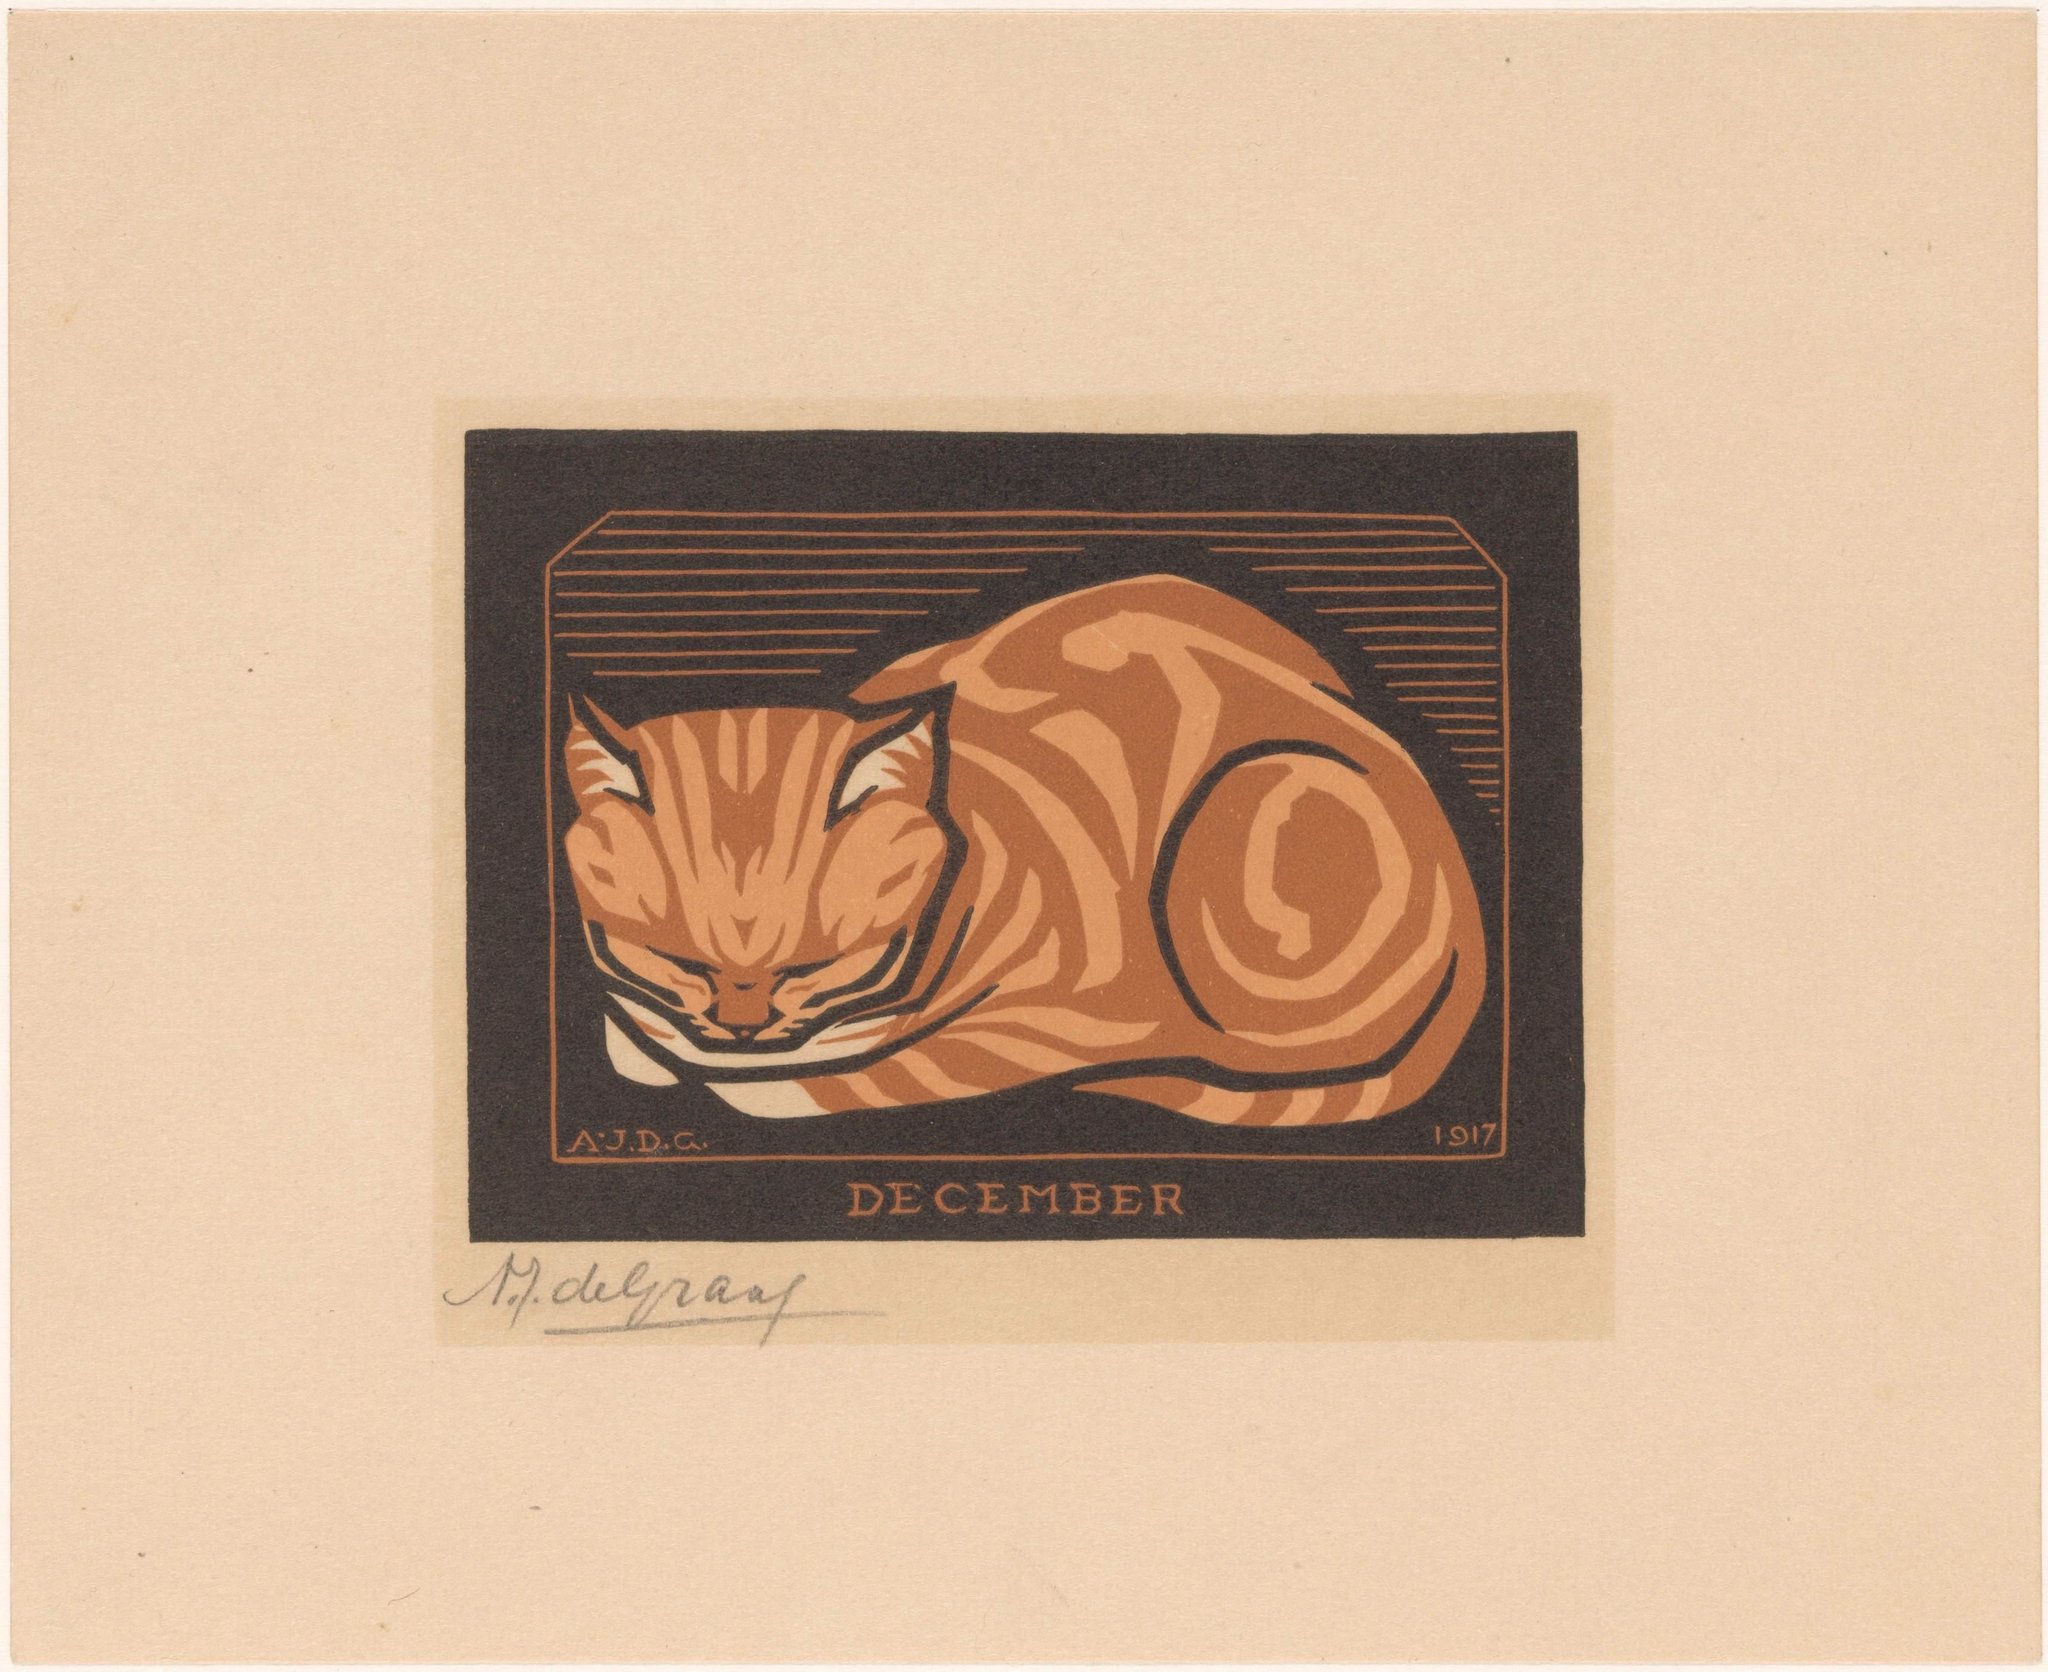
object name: print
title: December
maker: julie de graag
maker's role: draughtsman, print maker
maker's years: 1877-1924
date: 1917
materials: paper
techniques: woodcut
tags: december; 'decembre' (ripa), cat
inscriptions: collector's mark: Lugt 2228